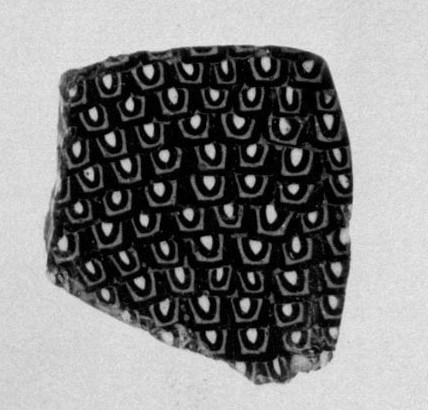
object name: inlay, feather pattern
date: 200 BCE-100 CE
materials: glass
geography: egypt